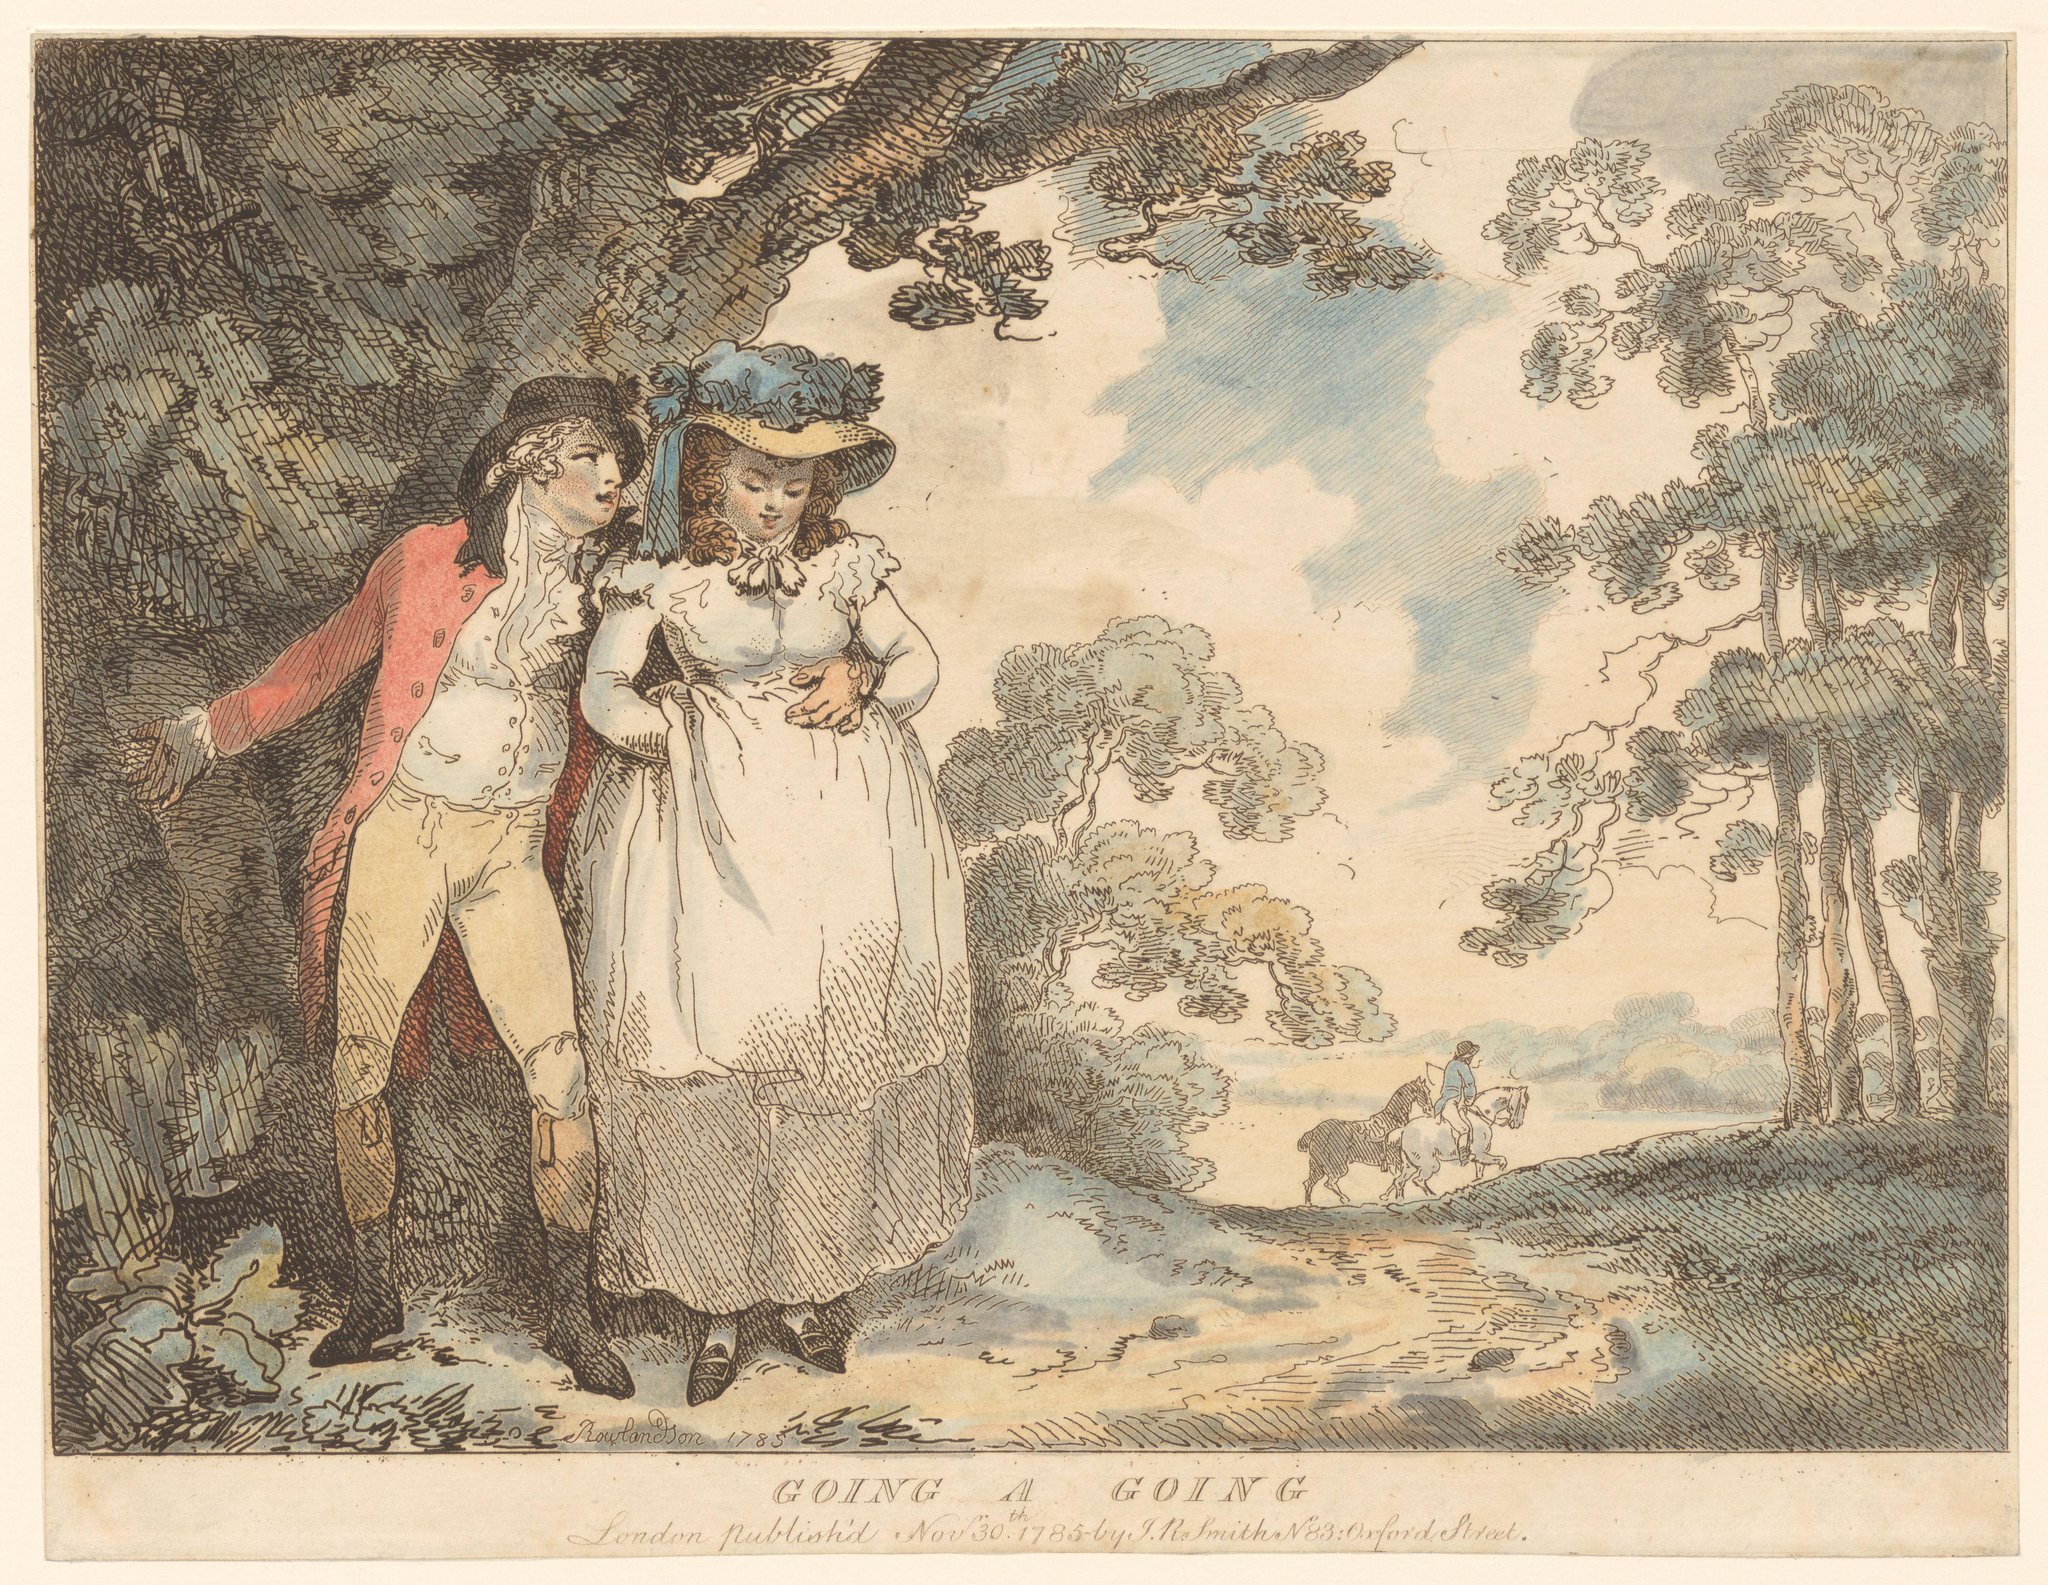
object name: print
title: Going a Going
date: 1785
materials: paper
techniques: etching, hand coloring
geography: london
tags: forest path or lane, courting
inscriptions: collector's mark: Lugt 2760, collector's mark: Lugt 2228